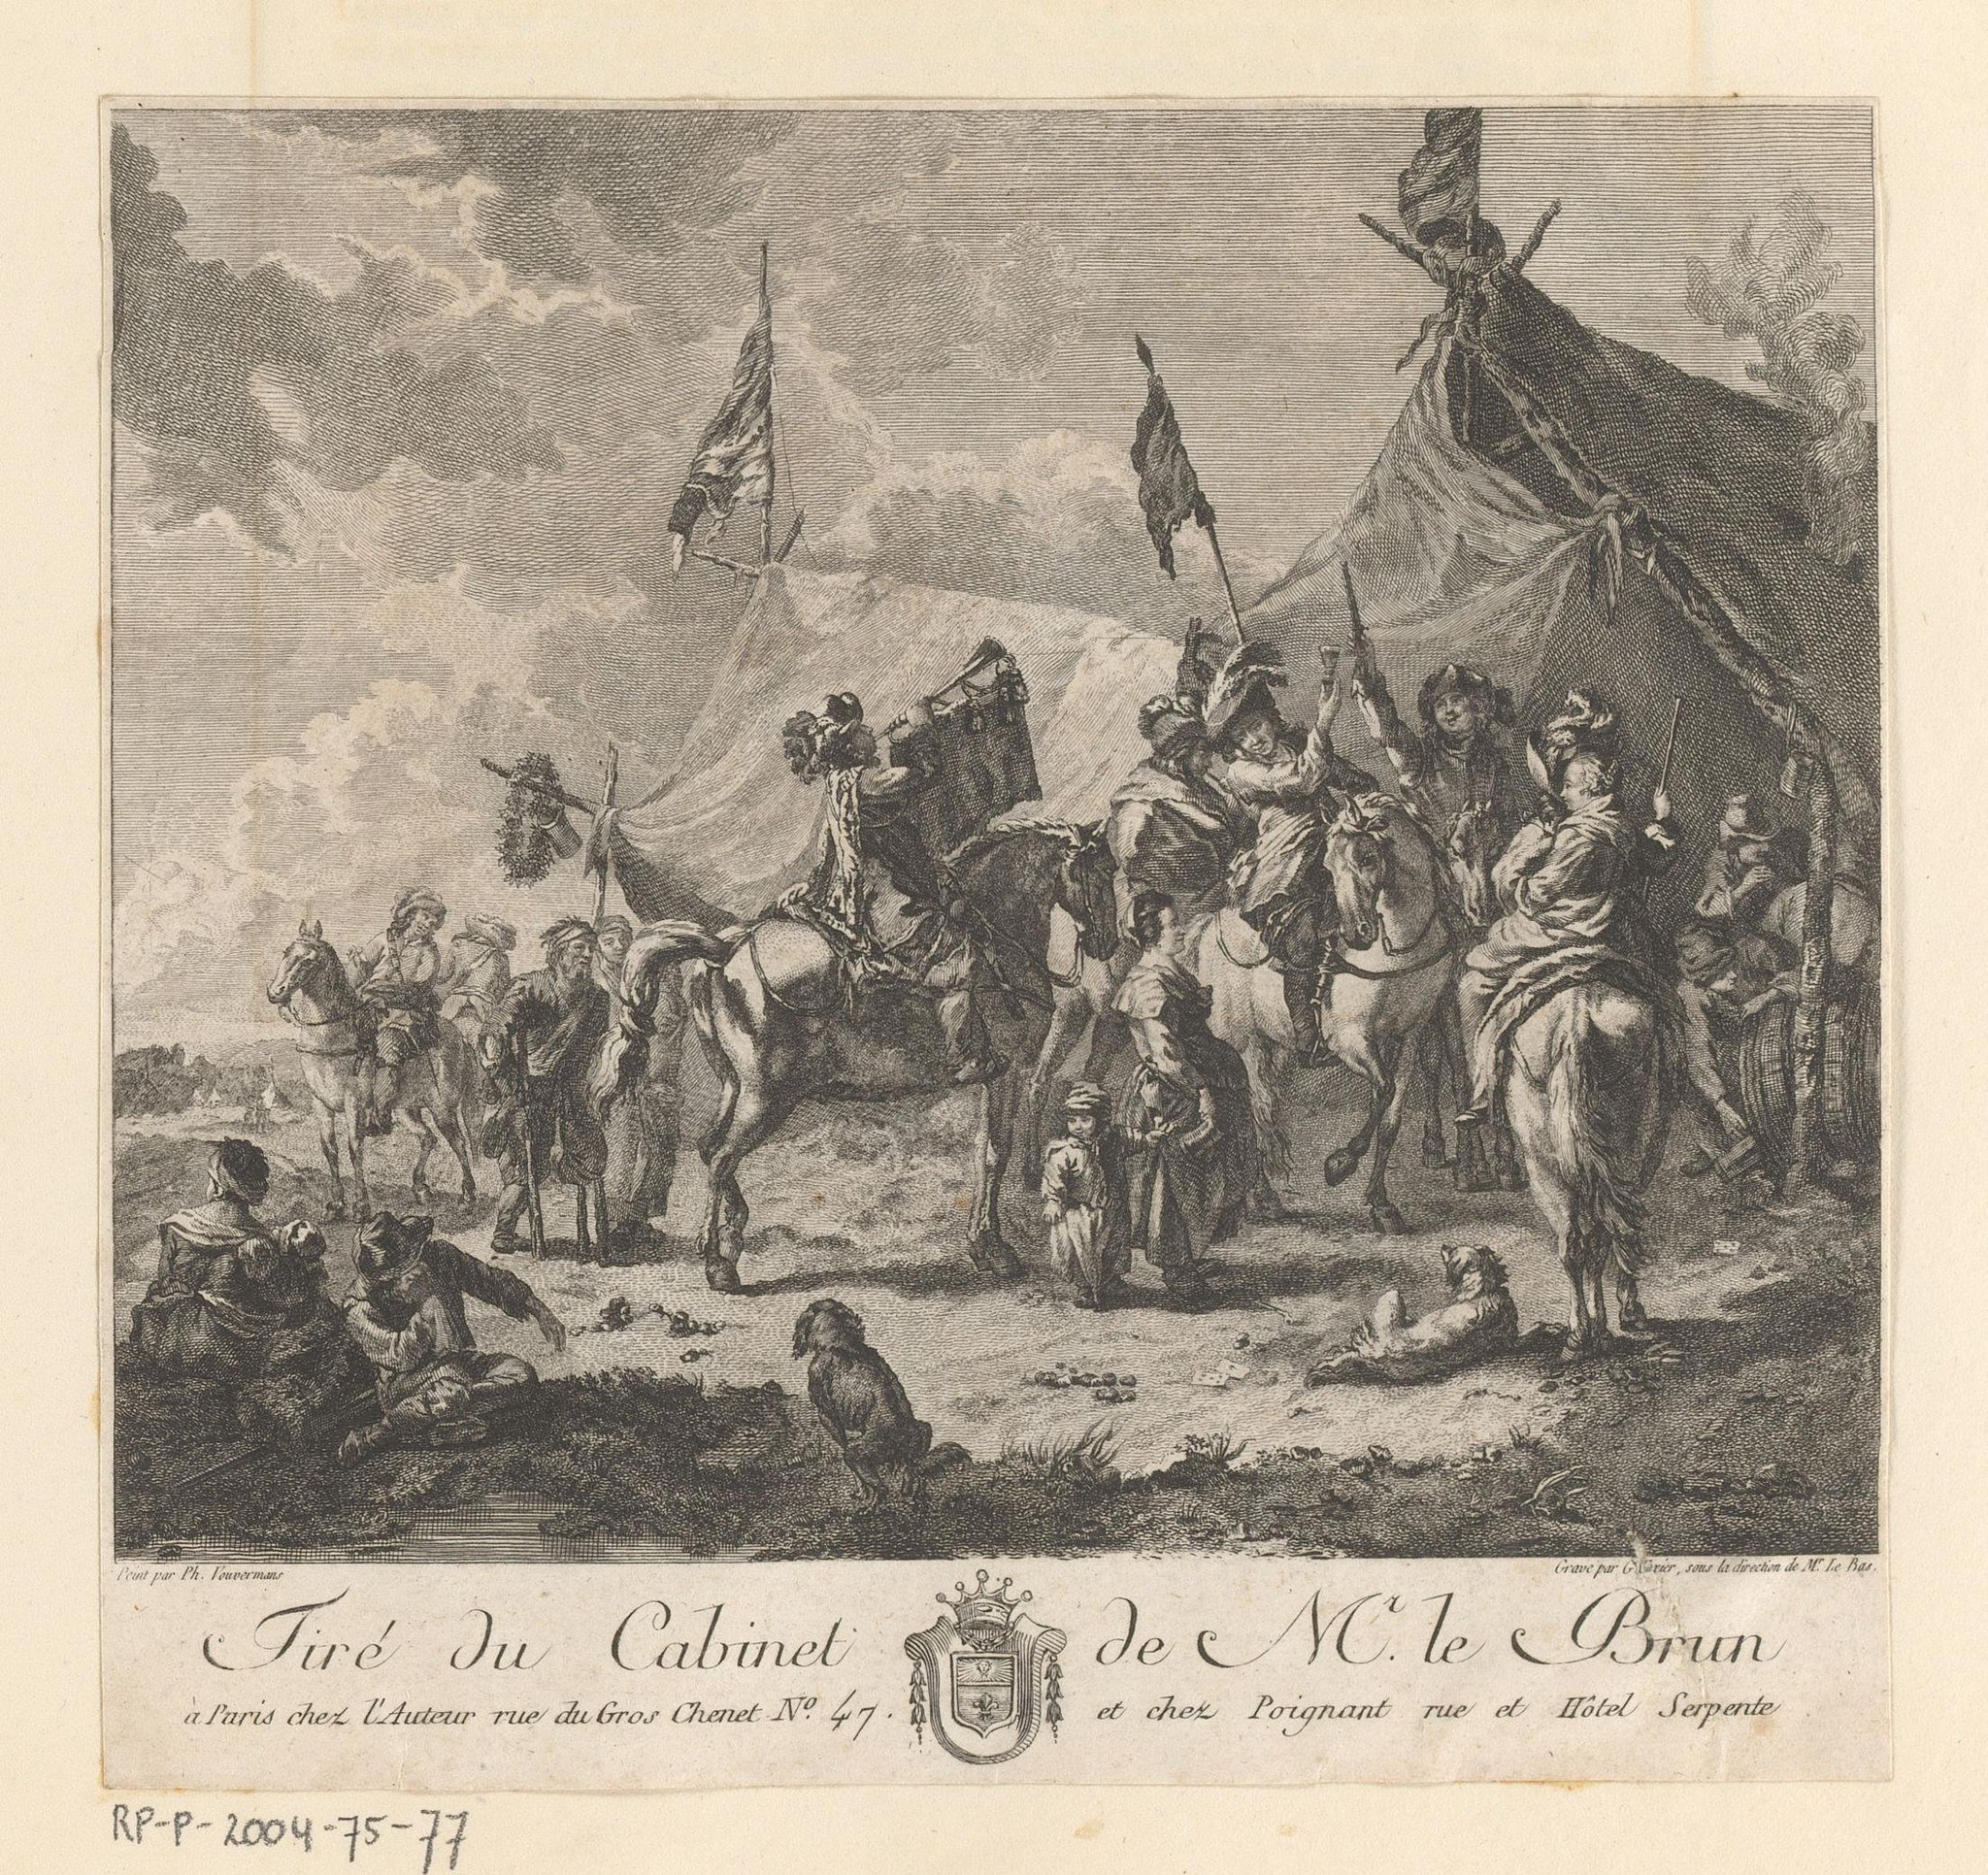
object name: print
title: Cavalerie bij de marketenster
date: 1776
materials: paper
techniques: engraving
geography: paris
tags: (military) camp with tents, the soldier; the soldier's life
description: Prent uit: Lebrun, Jean-Baptiste-Pierre. Galerie des peintres flamands, hollandais et allemands : ouvrage enrichi de deux cent une planches gravées d'après les meilleurs tableaux de ces maîtres, par les plus habiles artistes de France. 3 dln. Parijs: Jean-Baptiste-Pierre Lebrun, Parijs: Etienne Léon Poignant, Amsterdam: Pieter Fouquet (II), [1792-1796], dl. 2, p. 52. De samensteller heeft deze prent in het album geplakt als illustratie bij: Pilkington, Matthew en Johann Heinrich Füssli. A dictionary of painters, from the revival of the art to the present period. 4 dln. Londen: John Crowder, 1805, dl. 4, p. 656.